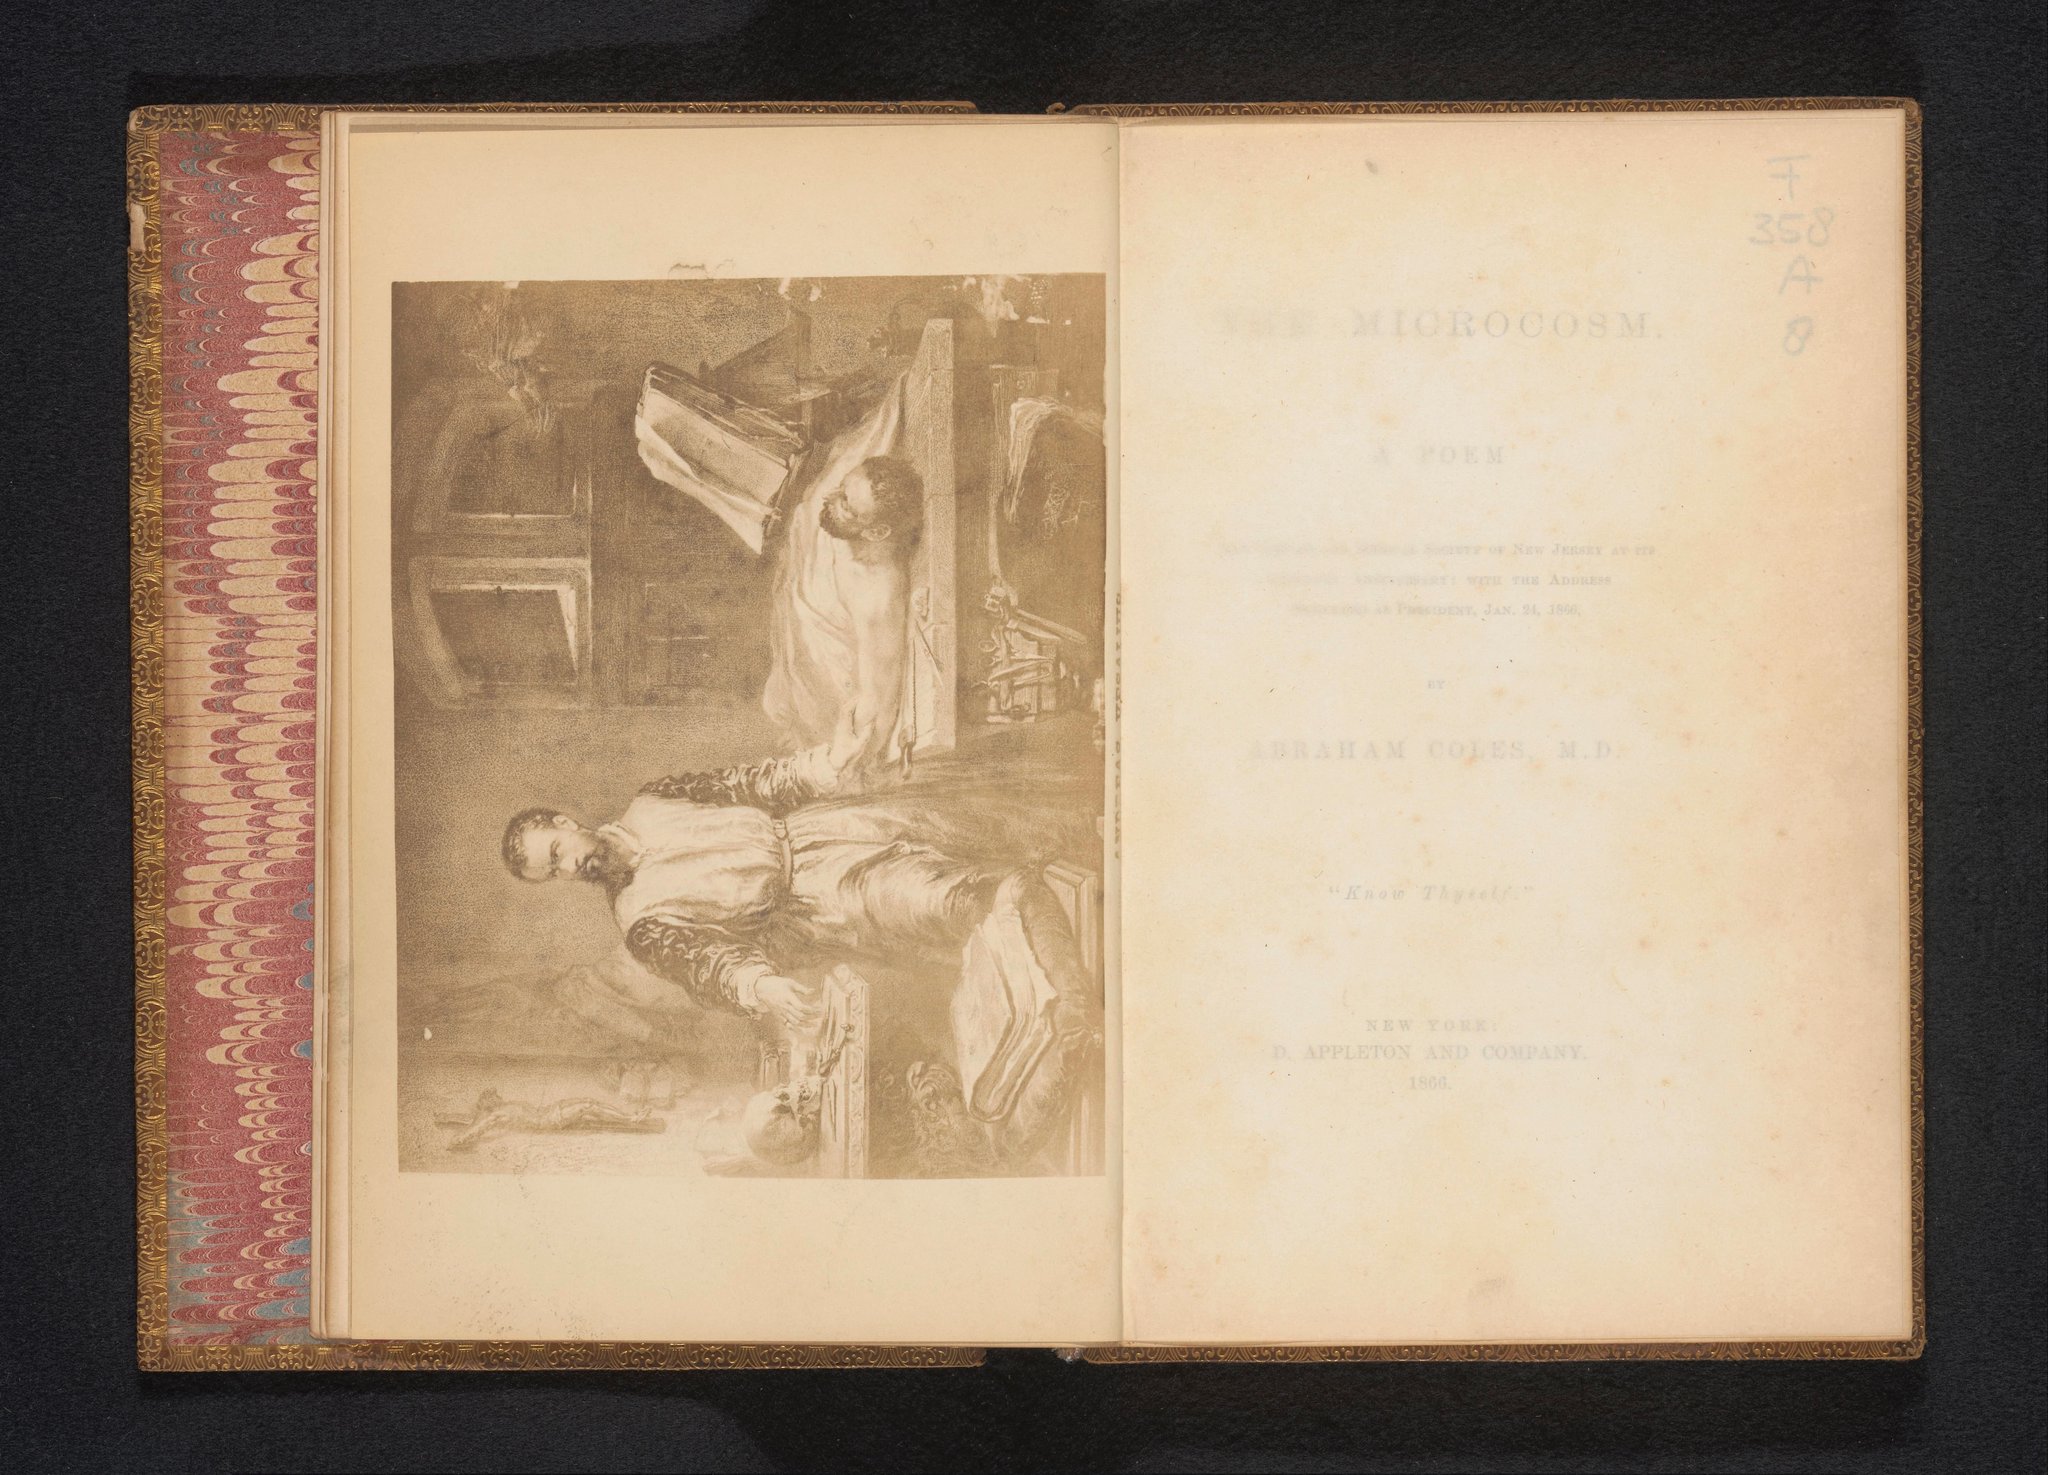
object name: page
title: Fotoreproductie van een portret van Andreas Vesalius door F. Hamman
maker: Anonymous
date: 1861-1866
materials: photographic support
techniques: albumen print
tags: brussels, the corpse